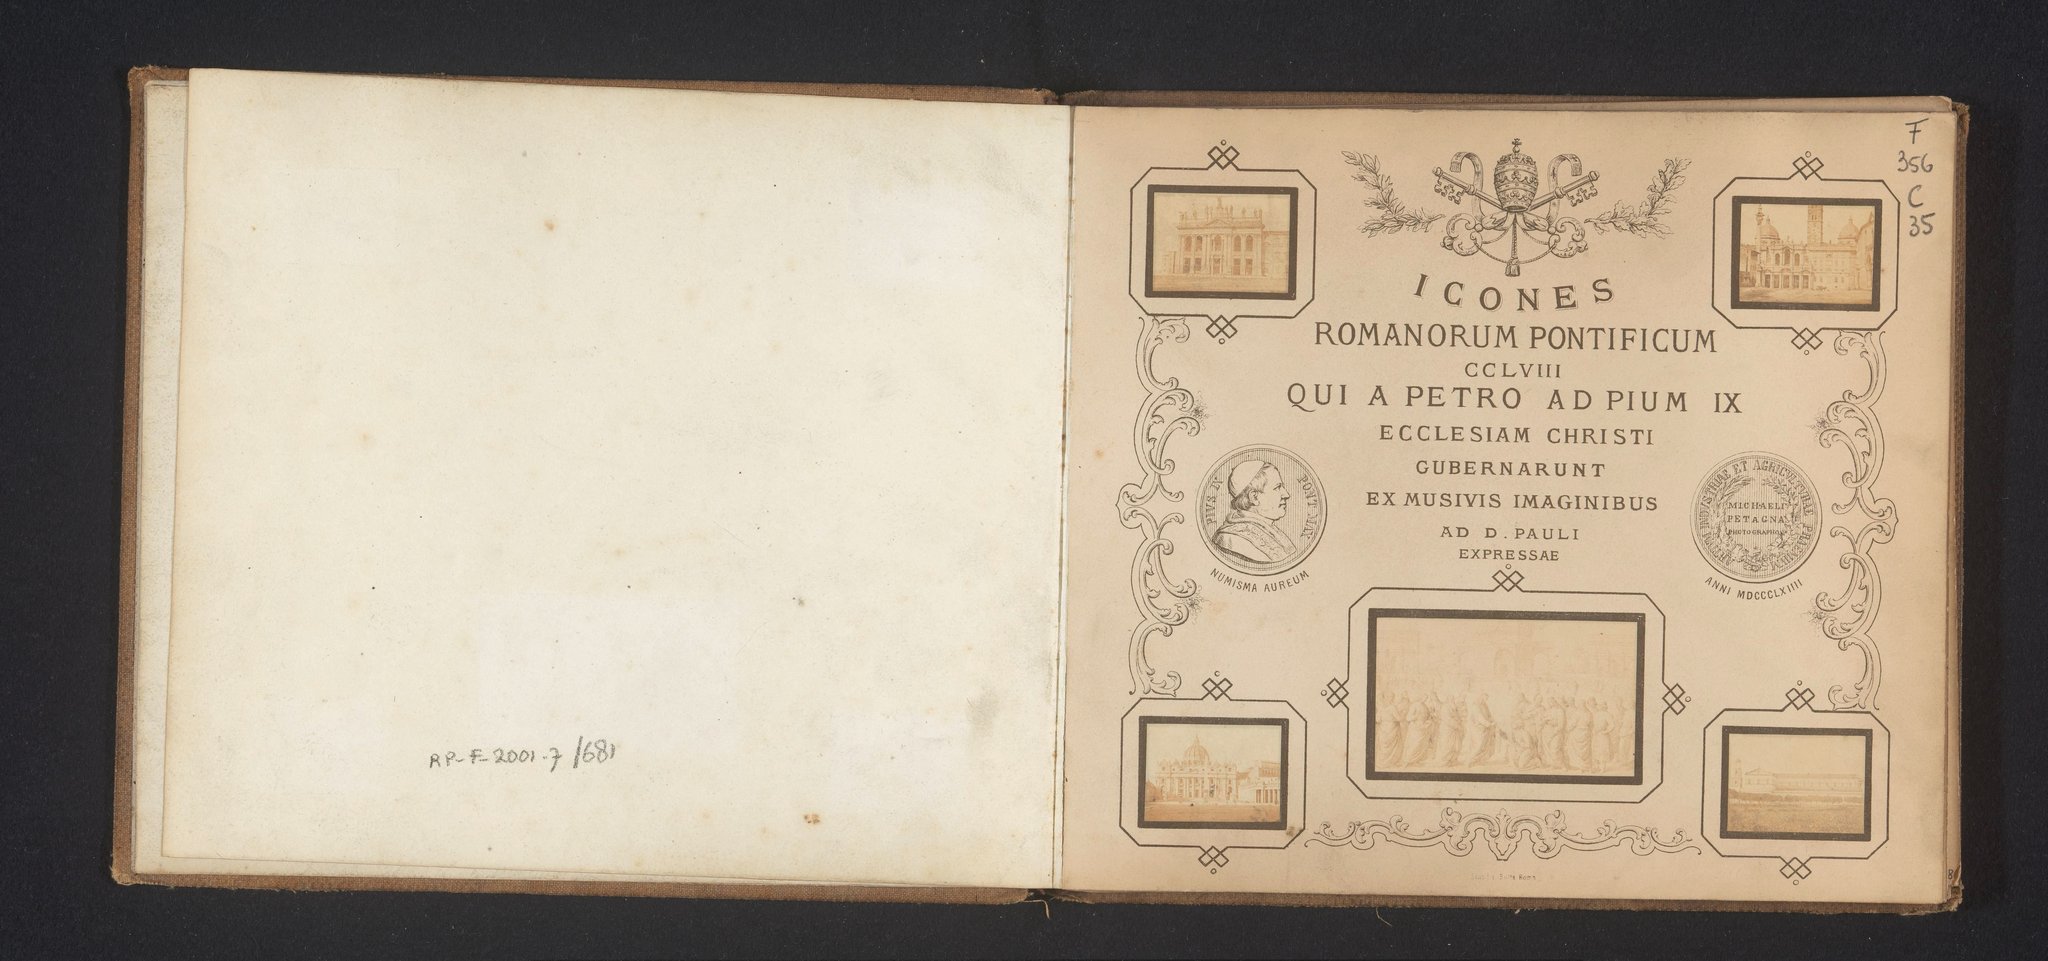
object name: book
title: Icones romanorum pontificorum CCLVIII qui a Petro ad Pium IX ecclesiam Christi gubernarunt ex musivis imaginibus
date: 1864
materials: linen, paper, photographic support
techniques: albumen print, decorated paper